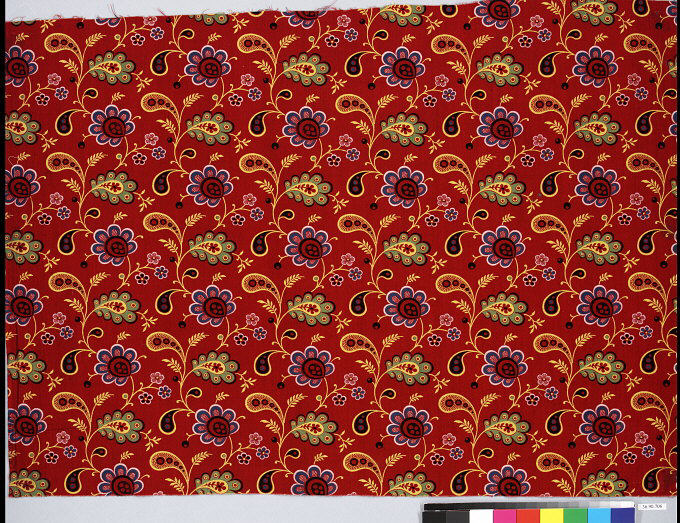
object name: piece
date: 1867-1900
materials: cotton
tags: flowers